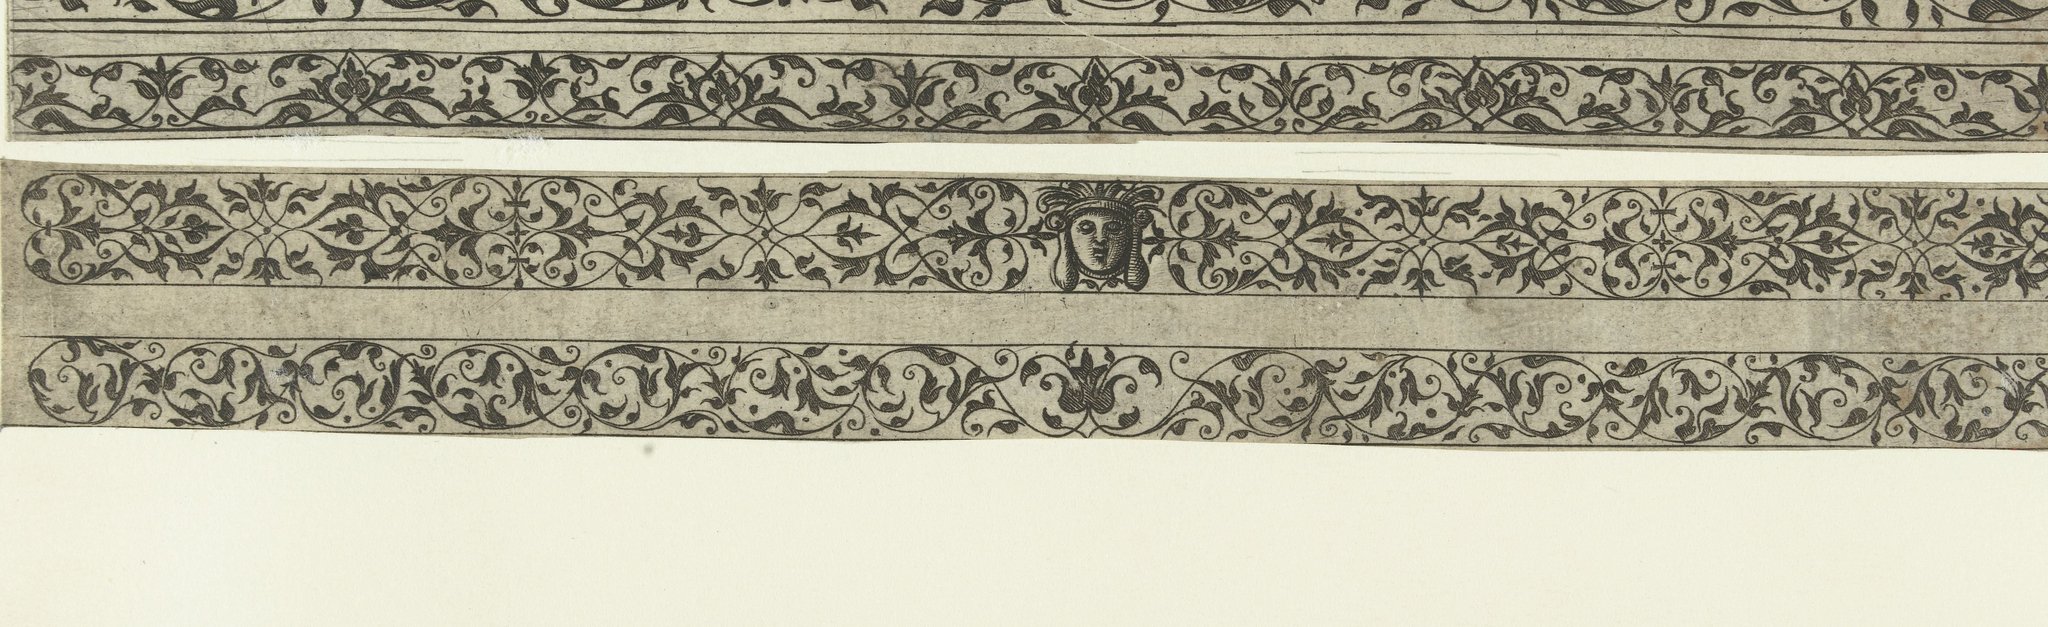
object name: ornament print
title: Friezen en geometrische motieven met moresken en arabesken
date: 1550-1580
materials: paper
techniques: engraving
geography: netherlands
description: In het midden van het bovenste en het een na onderste fries bevindt zich een mascaron. Een van 15 bladen afkomstig uit een serie van 23 met titelblad.